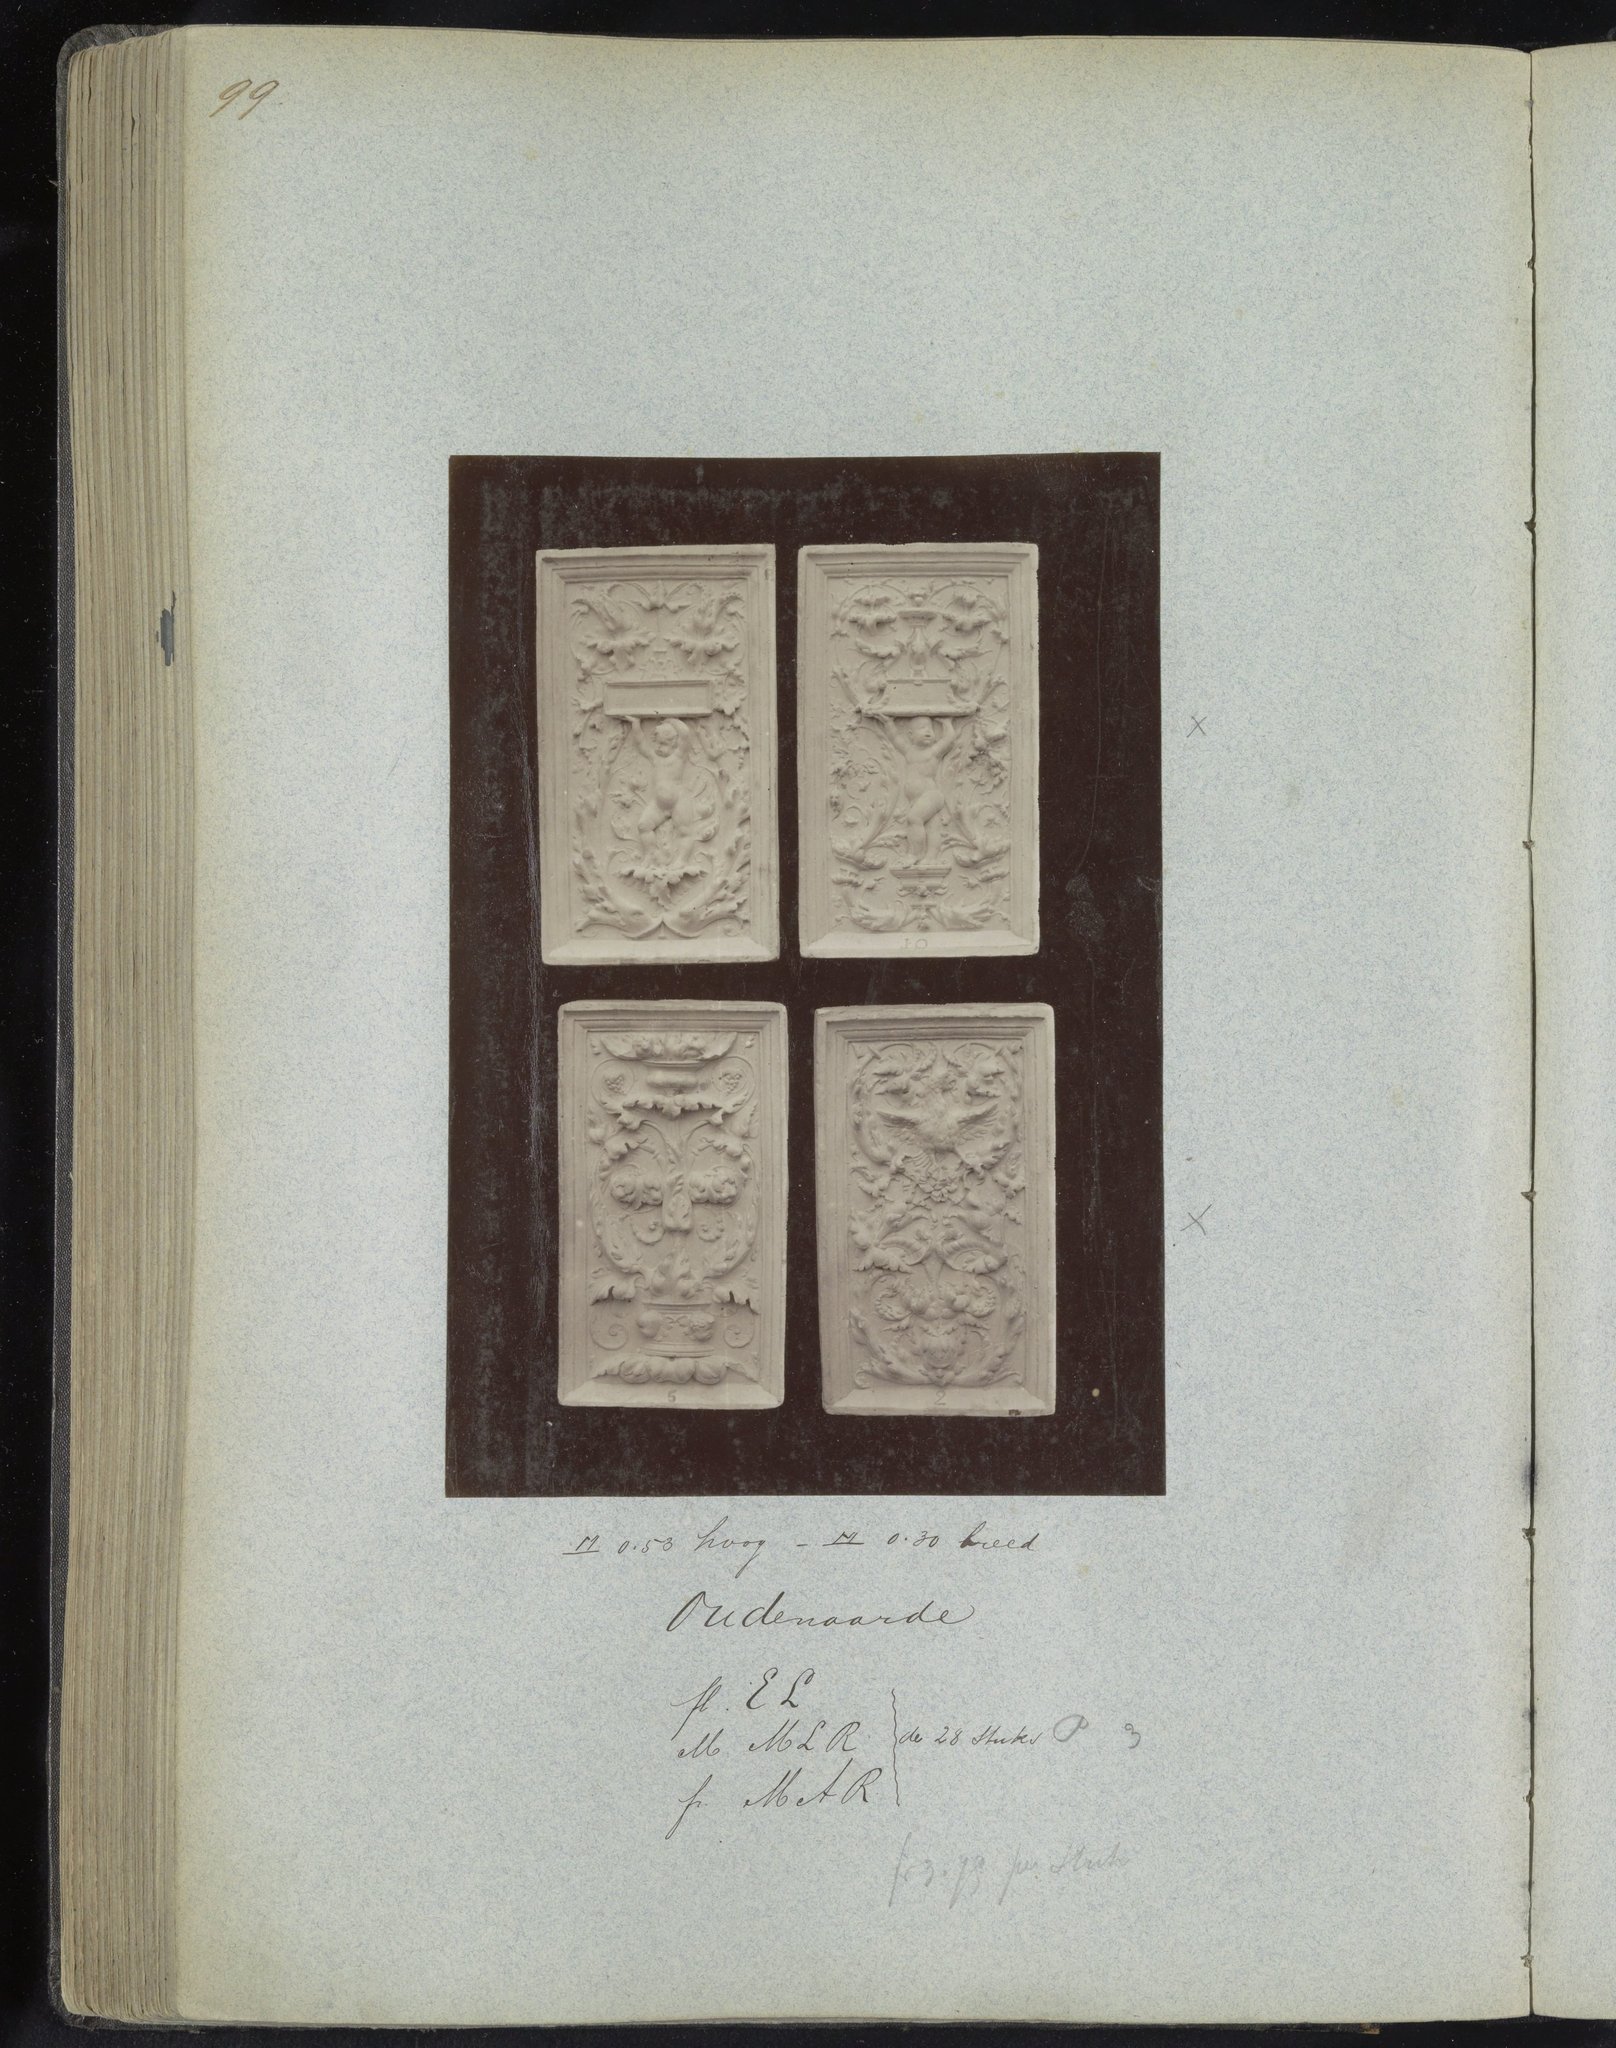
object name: photograph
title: Vier gipsen afgietsels van panelen, vermoedelijk afkomstig uit Oudenaarde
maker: Anonymous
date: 1875-1900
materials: paper, photographic support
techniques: albumen print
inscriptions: annotation: ‘M 0.53 hoog - M 0.30 breed’, annotation: ‘Oudenaarde’, annotation